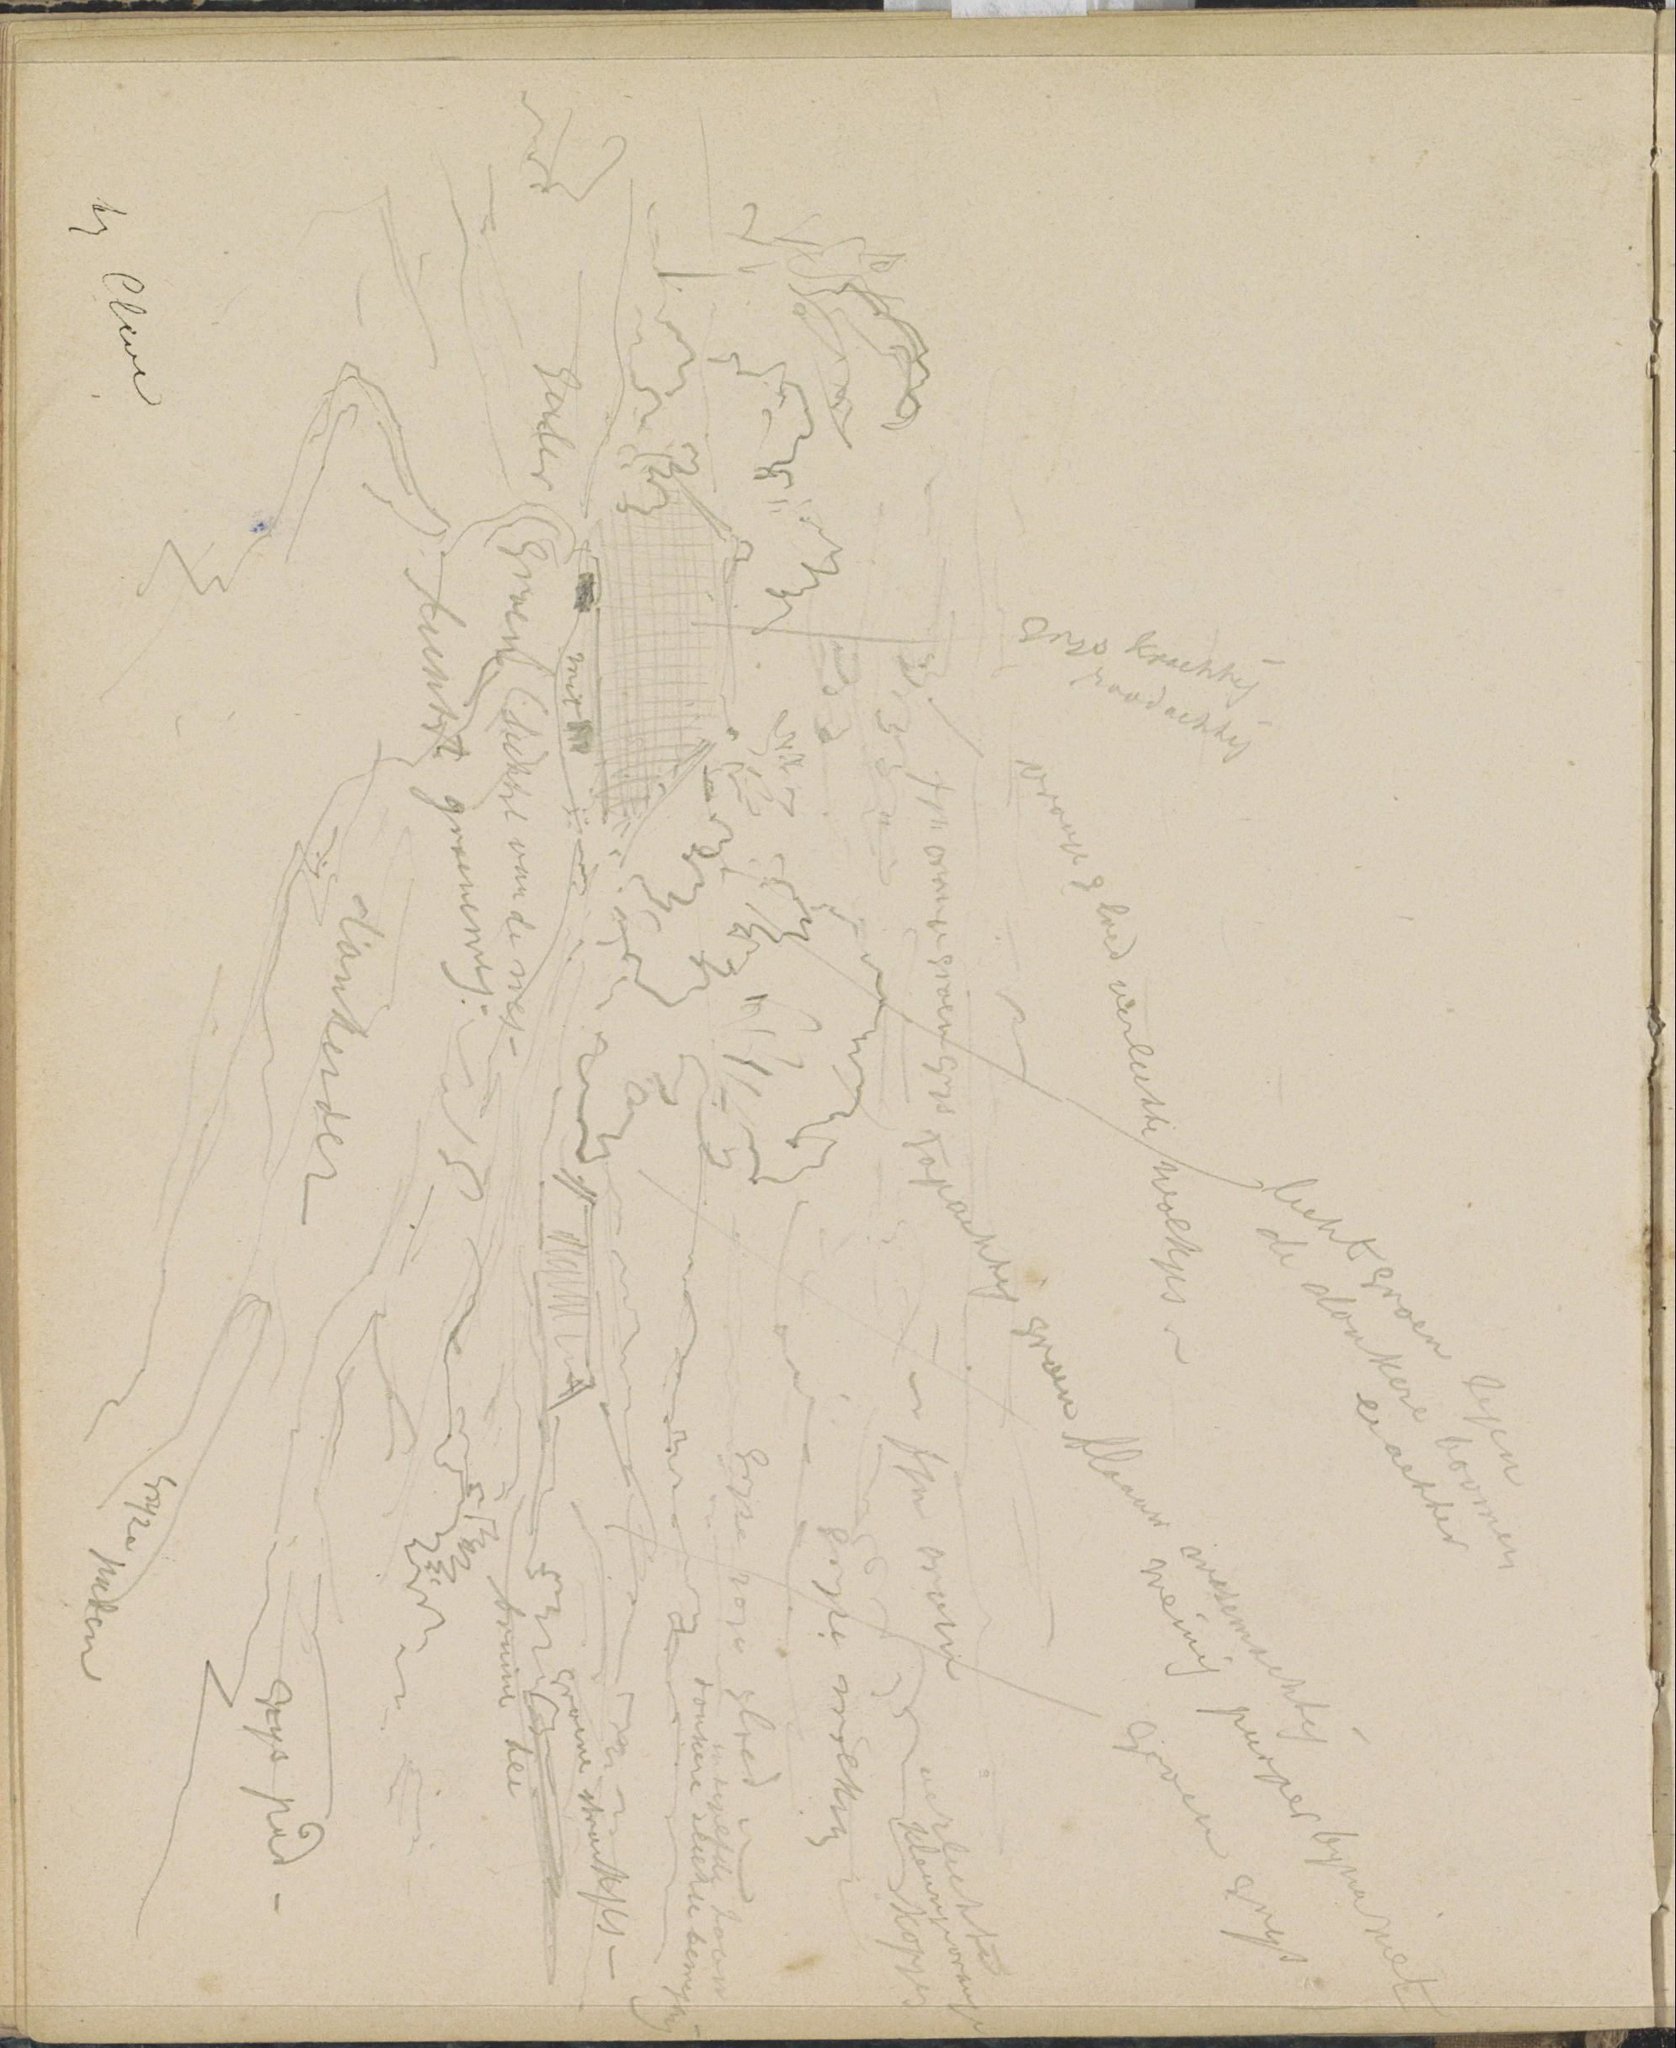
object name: sketchbook leaf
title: Landschap bij Kleef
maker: johannes tavenraat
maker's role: draughtsman, painter, print maker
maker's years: 1809-1881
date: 1841-1853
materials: paper, pencil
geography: cleves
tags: city-view, and landscape with man-made constructions, rural housing, e.g. country-house, villa, cottage, cleves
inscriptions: annotation: ‘bij Cleve’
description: Blad 70 verso uit een schetsboek met 87 bladen.